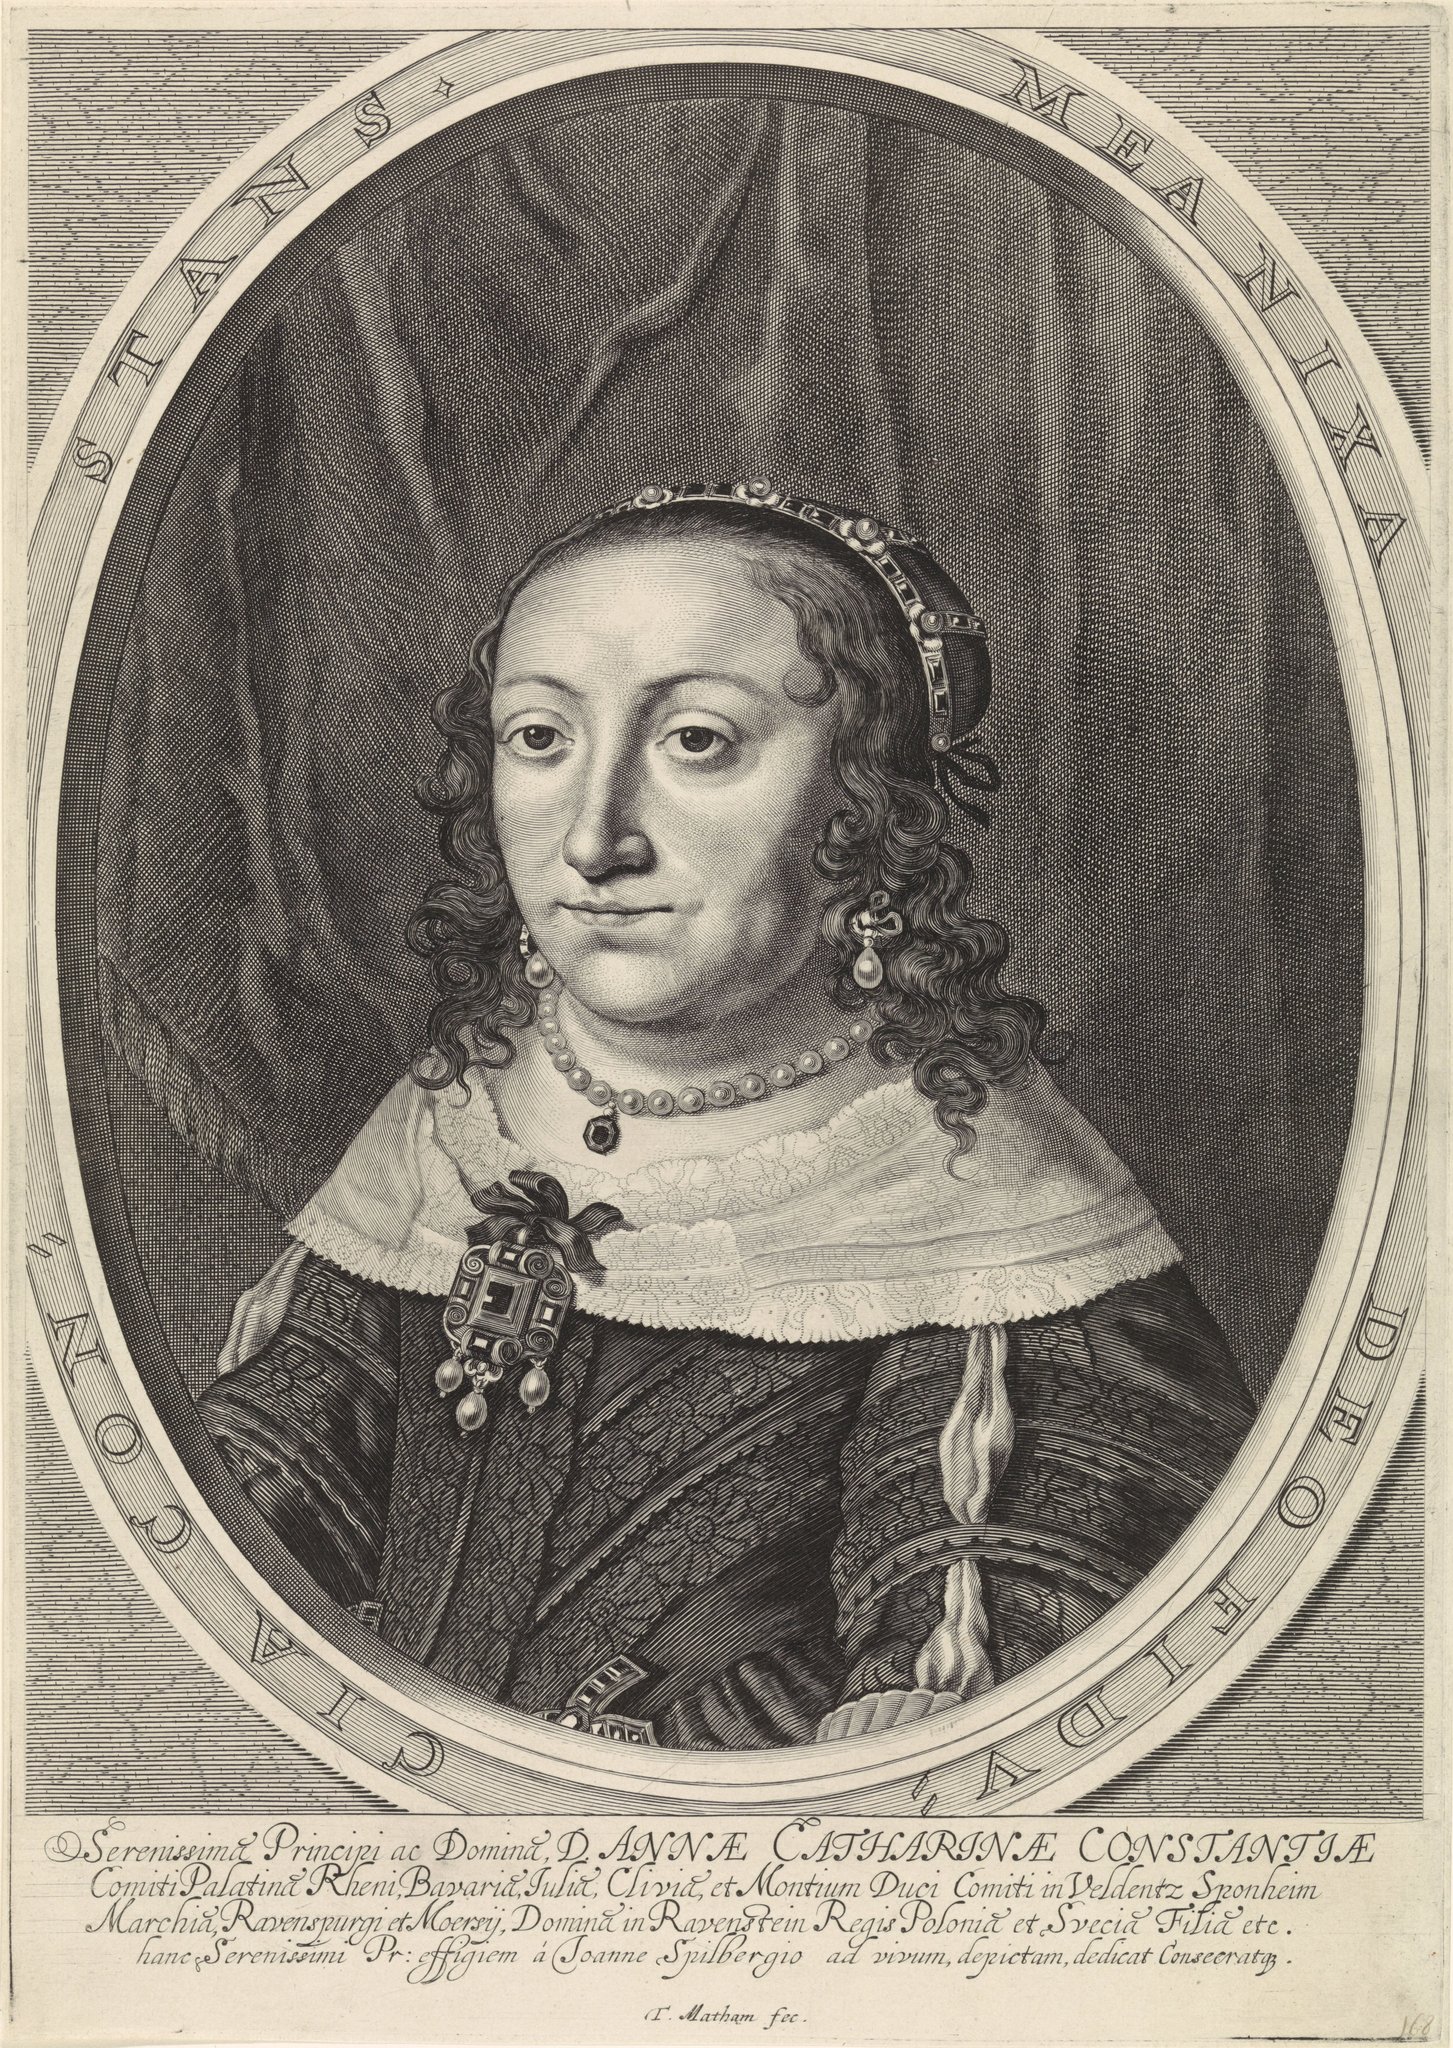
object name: print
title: Portret van Anna Catharina Constance, paltsgravin van Palts-Neuburg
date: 1635-1653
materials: paper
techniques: engraving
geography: northern netherlands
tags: ear-rings (+ women's clothes), brooch, agraffe, clasp (+ women's clothes), necklace (+ women's clothes)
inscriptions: collector's mark: Lugt 240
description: Portret van Anna Catharina Constance, paltsgravin van Palts-Neuburg, dochter van Wolfgang Willem van de Palts-Neuburg en zijn tweede vrouw Catharina Charlotta. Om haar hals een parelsnoer met een hanger.